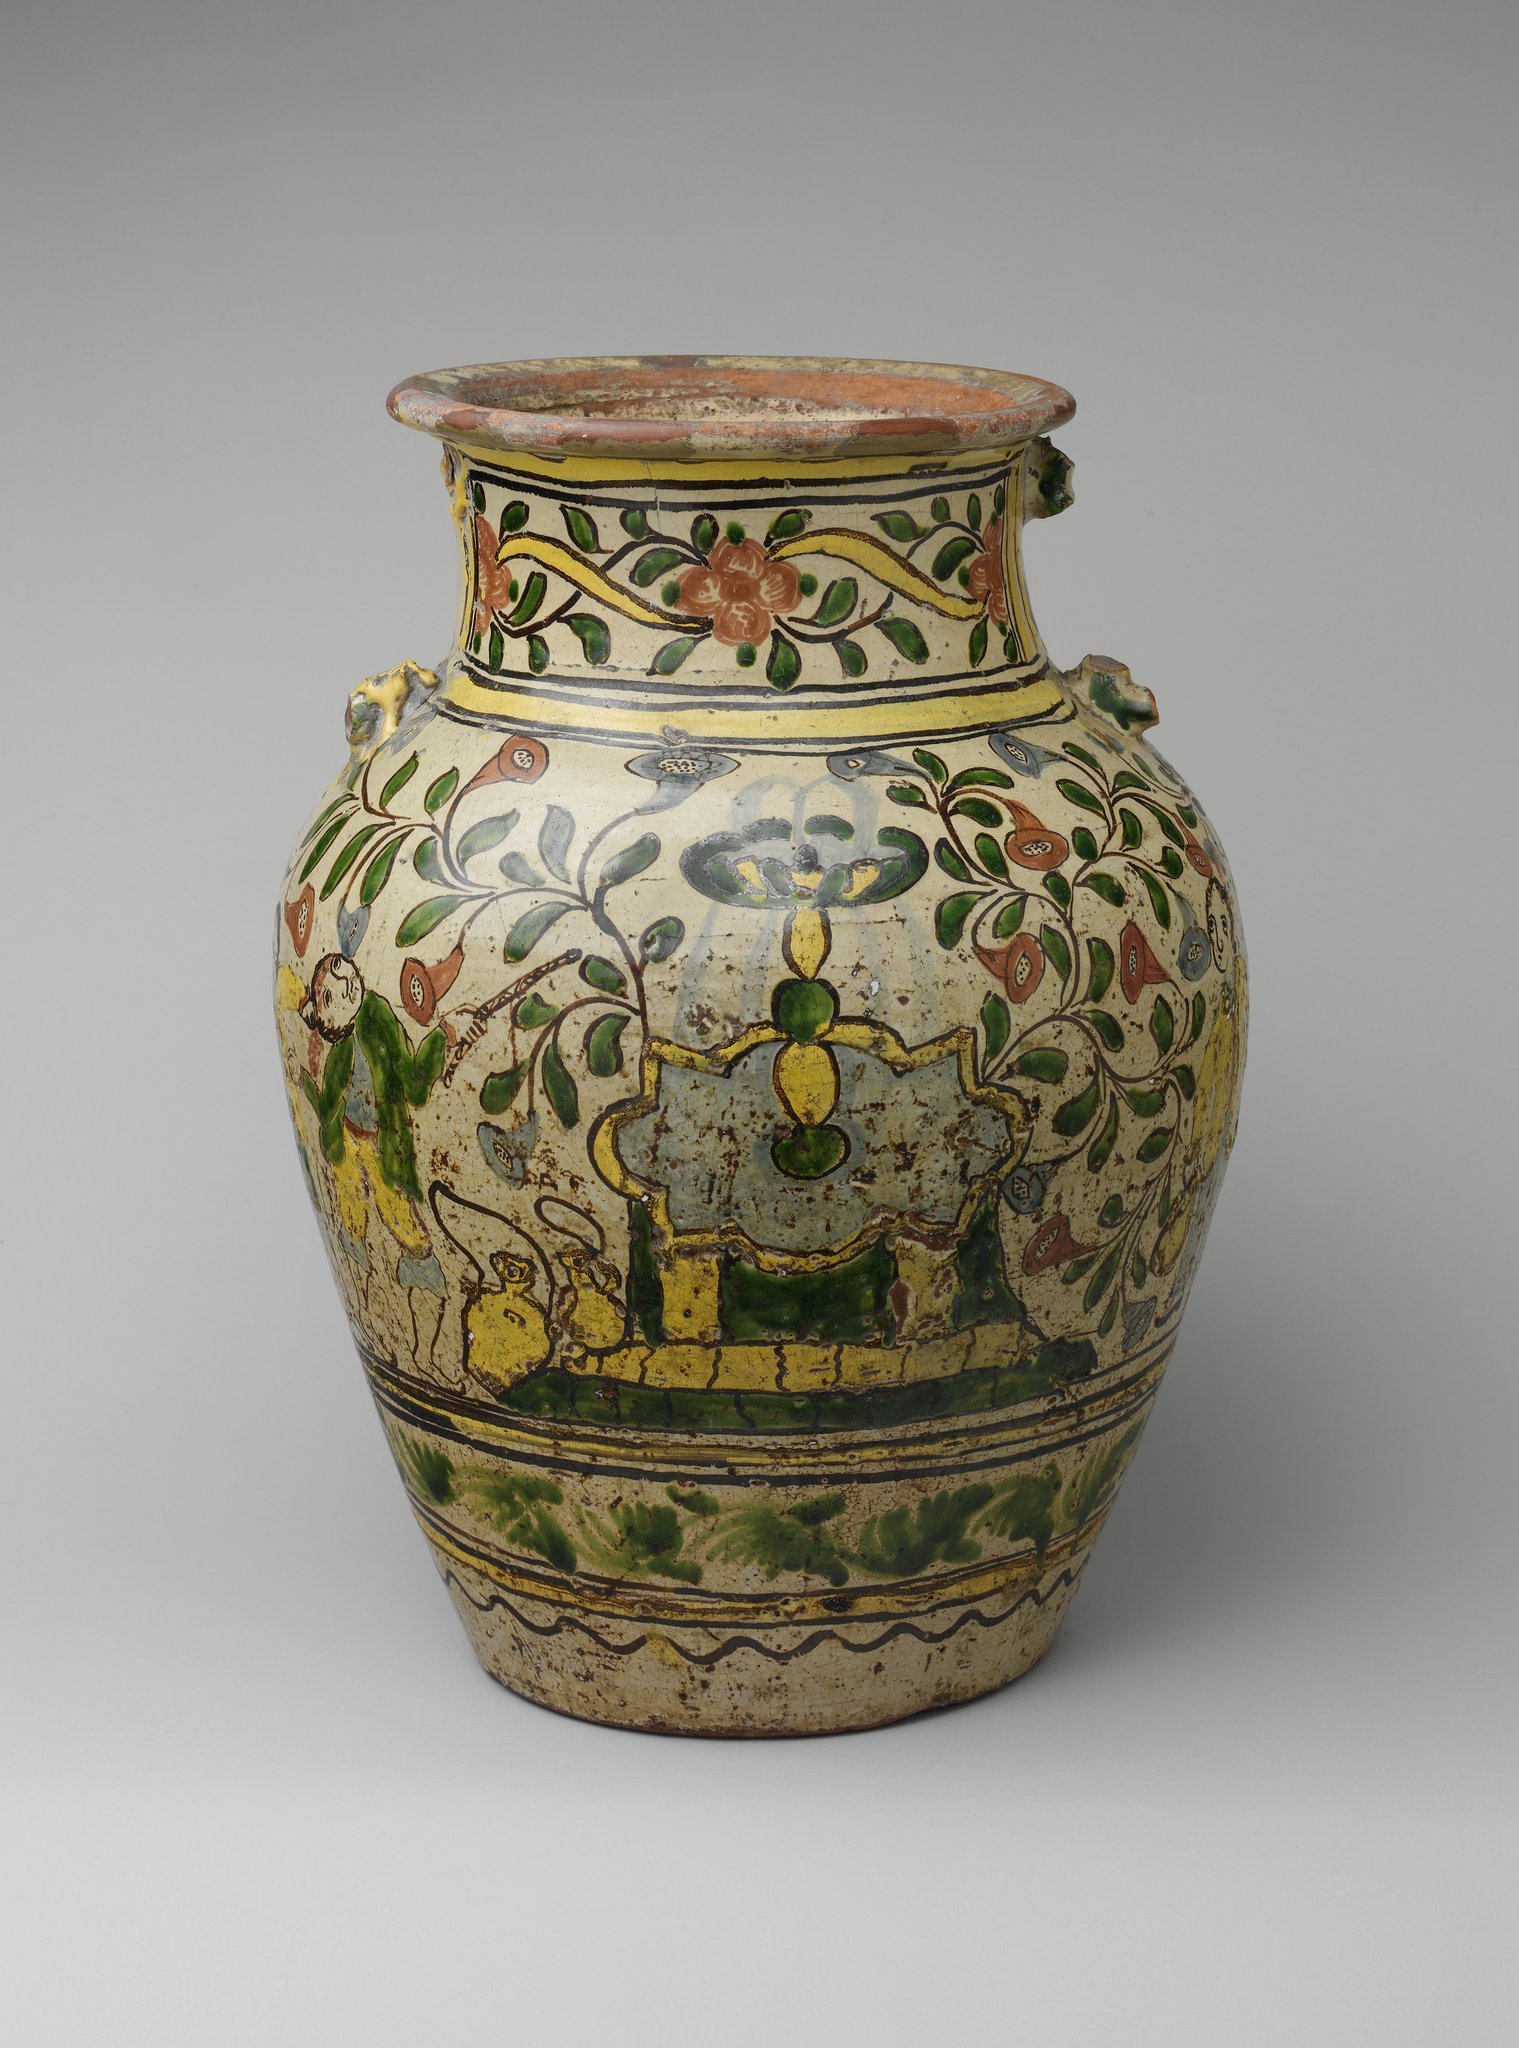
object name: jar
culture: mexican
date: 1840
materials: earthenware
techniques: glazing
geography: mexico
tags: men,flowers